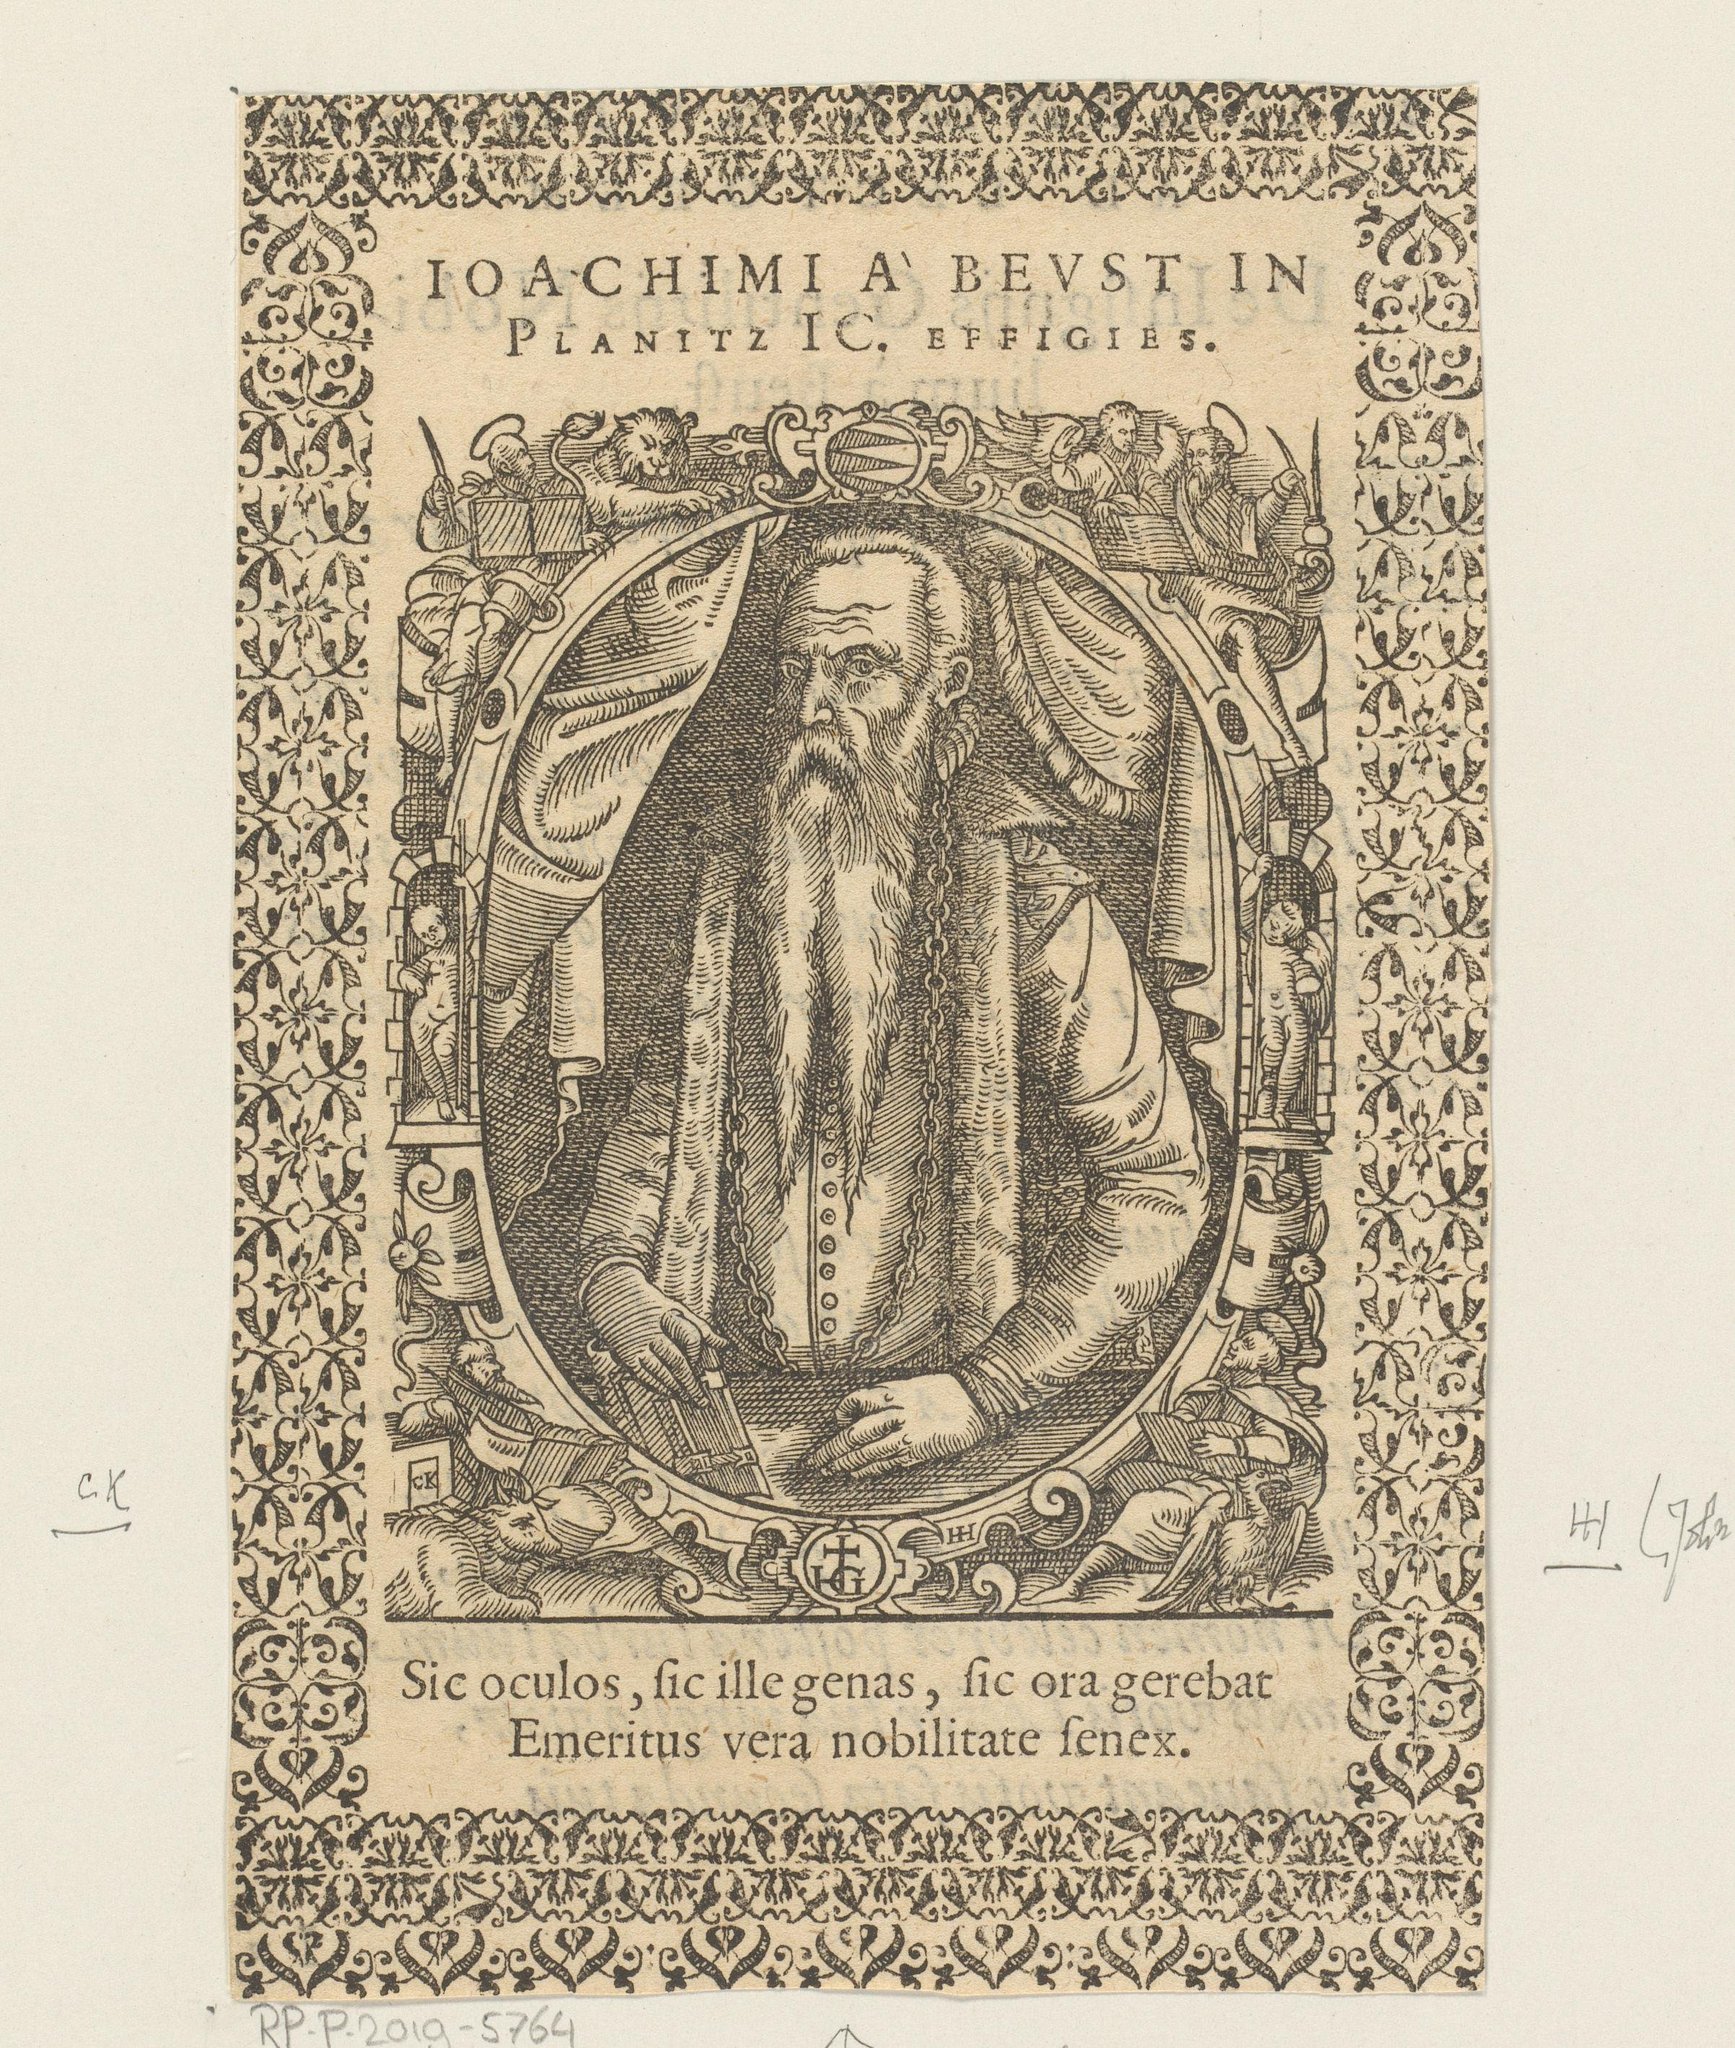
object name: book illustration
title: Portret van Joachim von Beust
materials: paper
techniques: letterpress printing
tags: historical persons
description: Prent verschenen in: Beust, Joachim von. Orthodoxa enarratio Evangeliorum (...). Leipzig: Henning I Grosse, 1599. Prent mogelijk uit eerdere editie of andere publicatie.